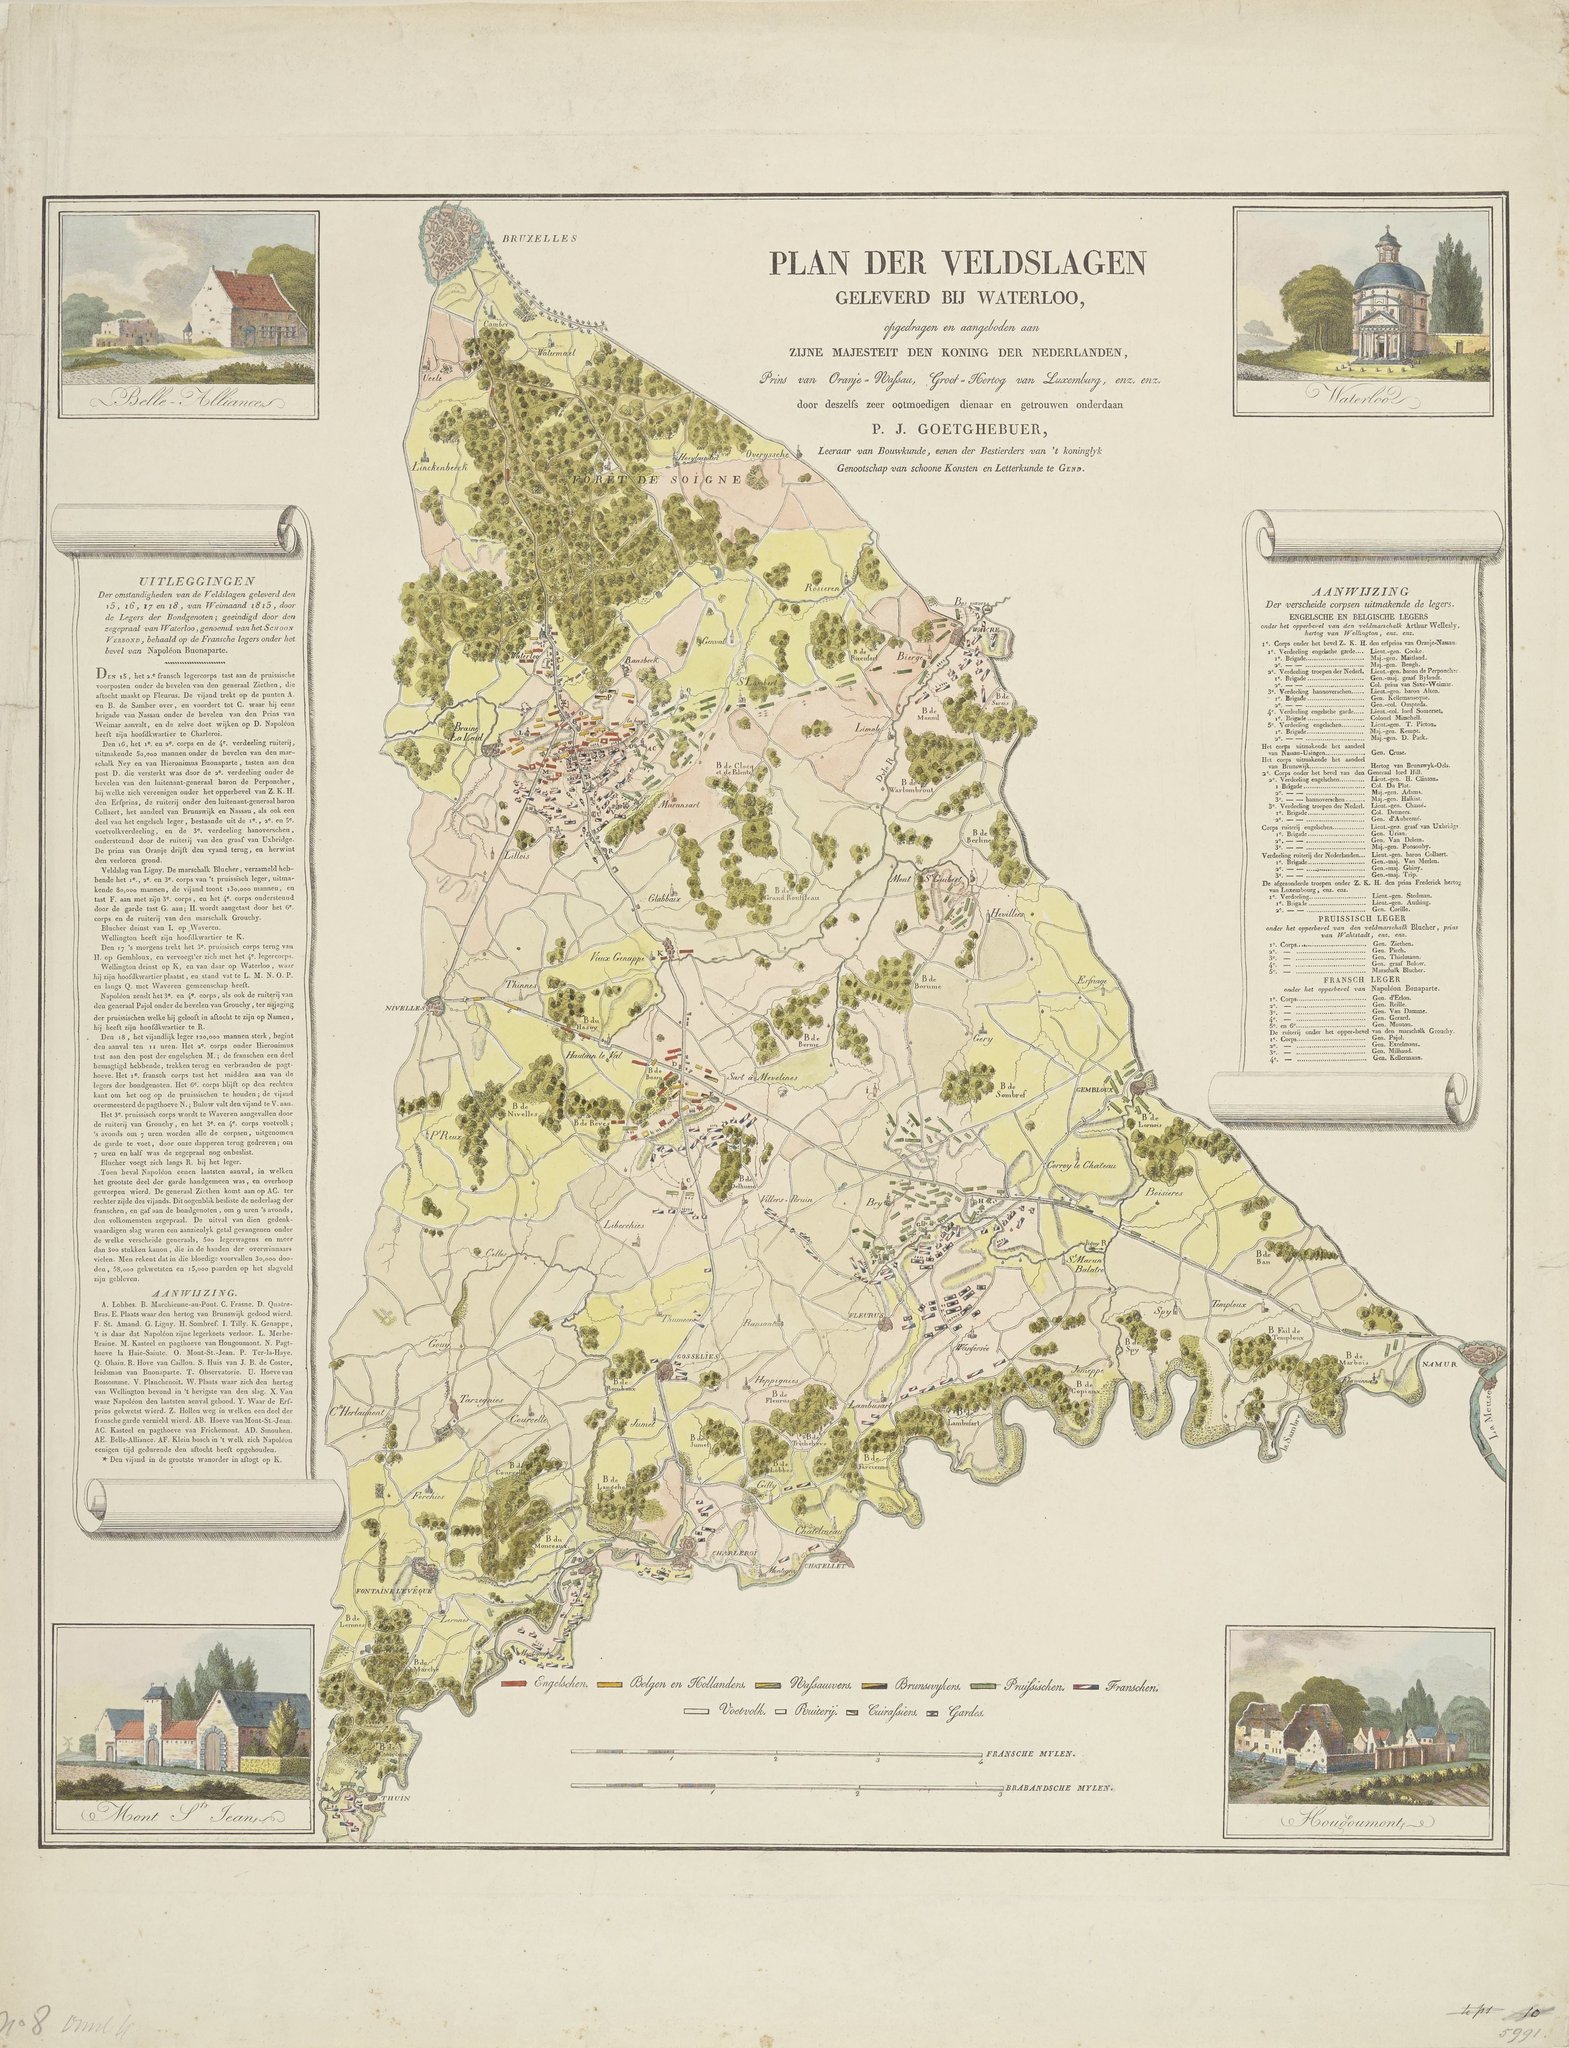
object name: print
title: Kaart van de slagen bij Waterloo, 1815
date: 1815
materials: paper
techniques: etching, hand coloring, letterpress printing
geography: ghent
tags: maps of separate countries or regions, battle arrays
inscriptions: collector's mark: Lugt 2228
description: Kaart van het gebied waarin de veldslagen bij Quatre-Bras en Waterloo zijn uitgevochten, 15-18 juni 1815. Centraal de kaart met ligging van de legers, links en rechts banderollen met de legenda en een overzicht van de onderdelen van de verschillende legers. In de vier hoeken kleine voorstellingen van La Belle Alliance, de Sint-Jozefskerk te Waterloo, de ruïne van de hoeve van Hougoumont en de hoeve la Haye-Sainte in Mont-Saint-Jean.